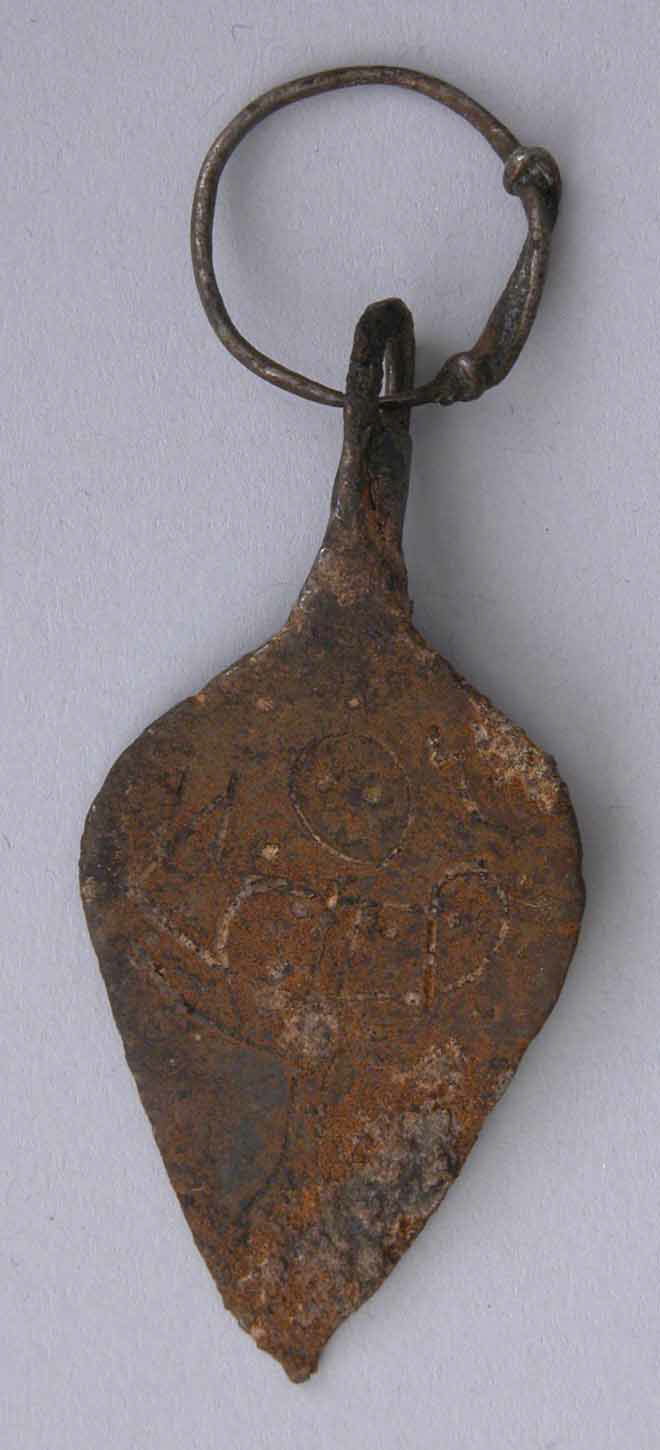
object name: earring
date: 201-1200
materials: iron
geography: egypt